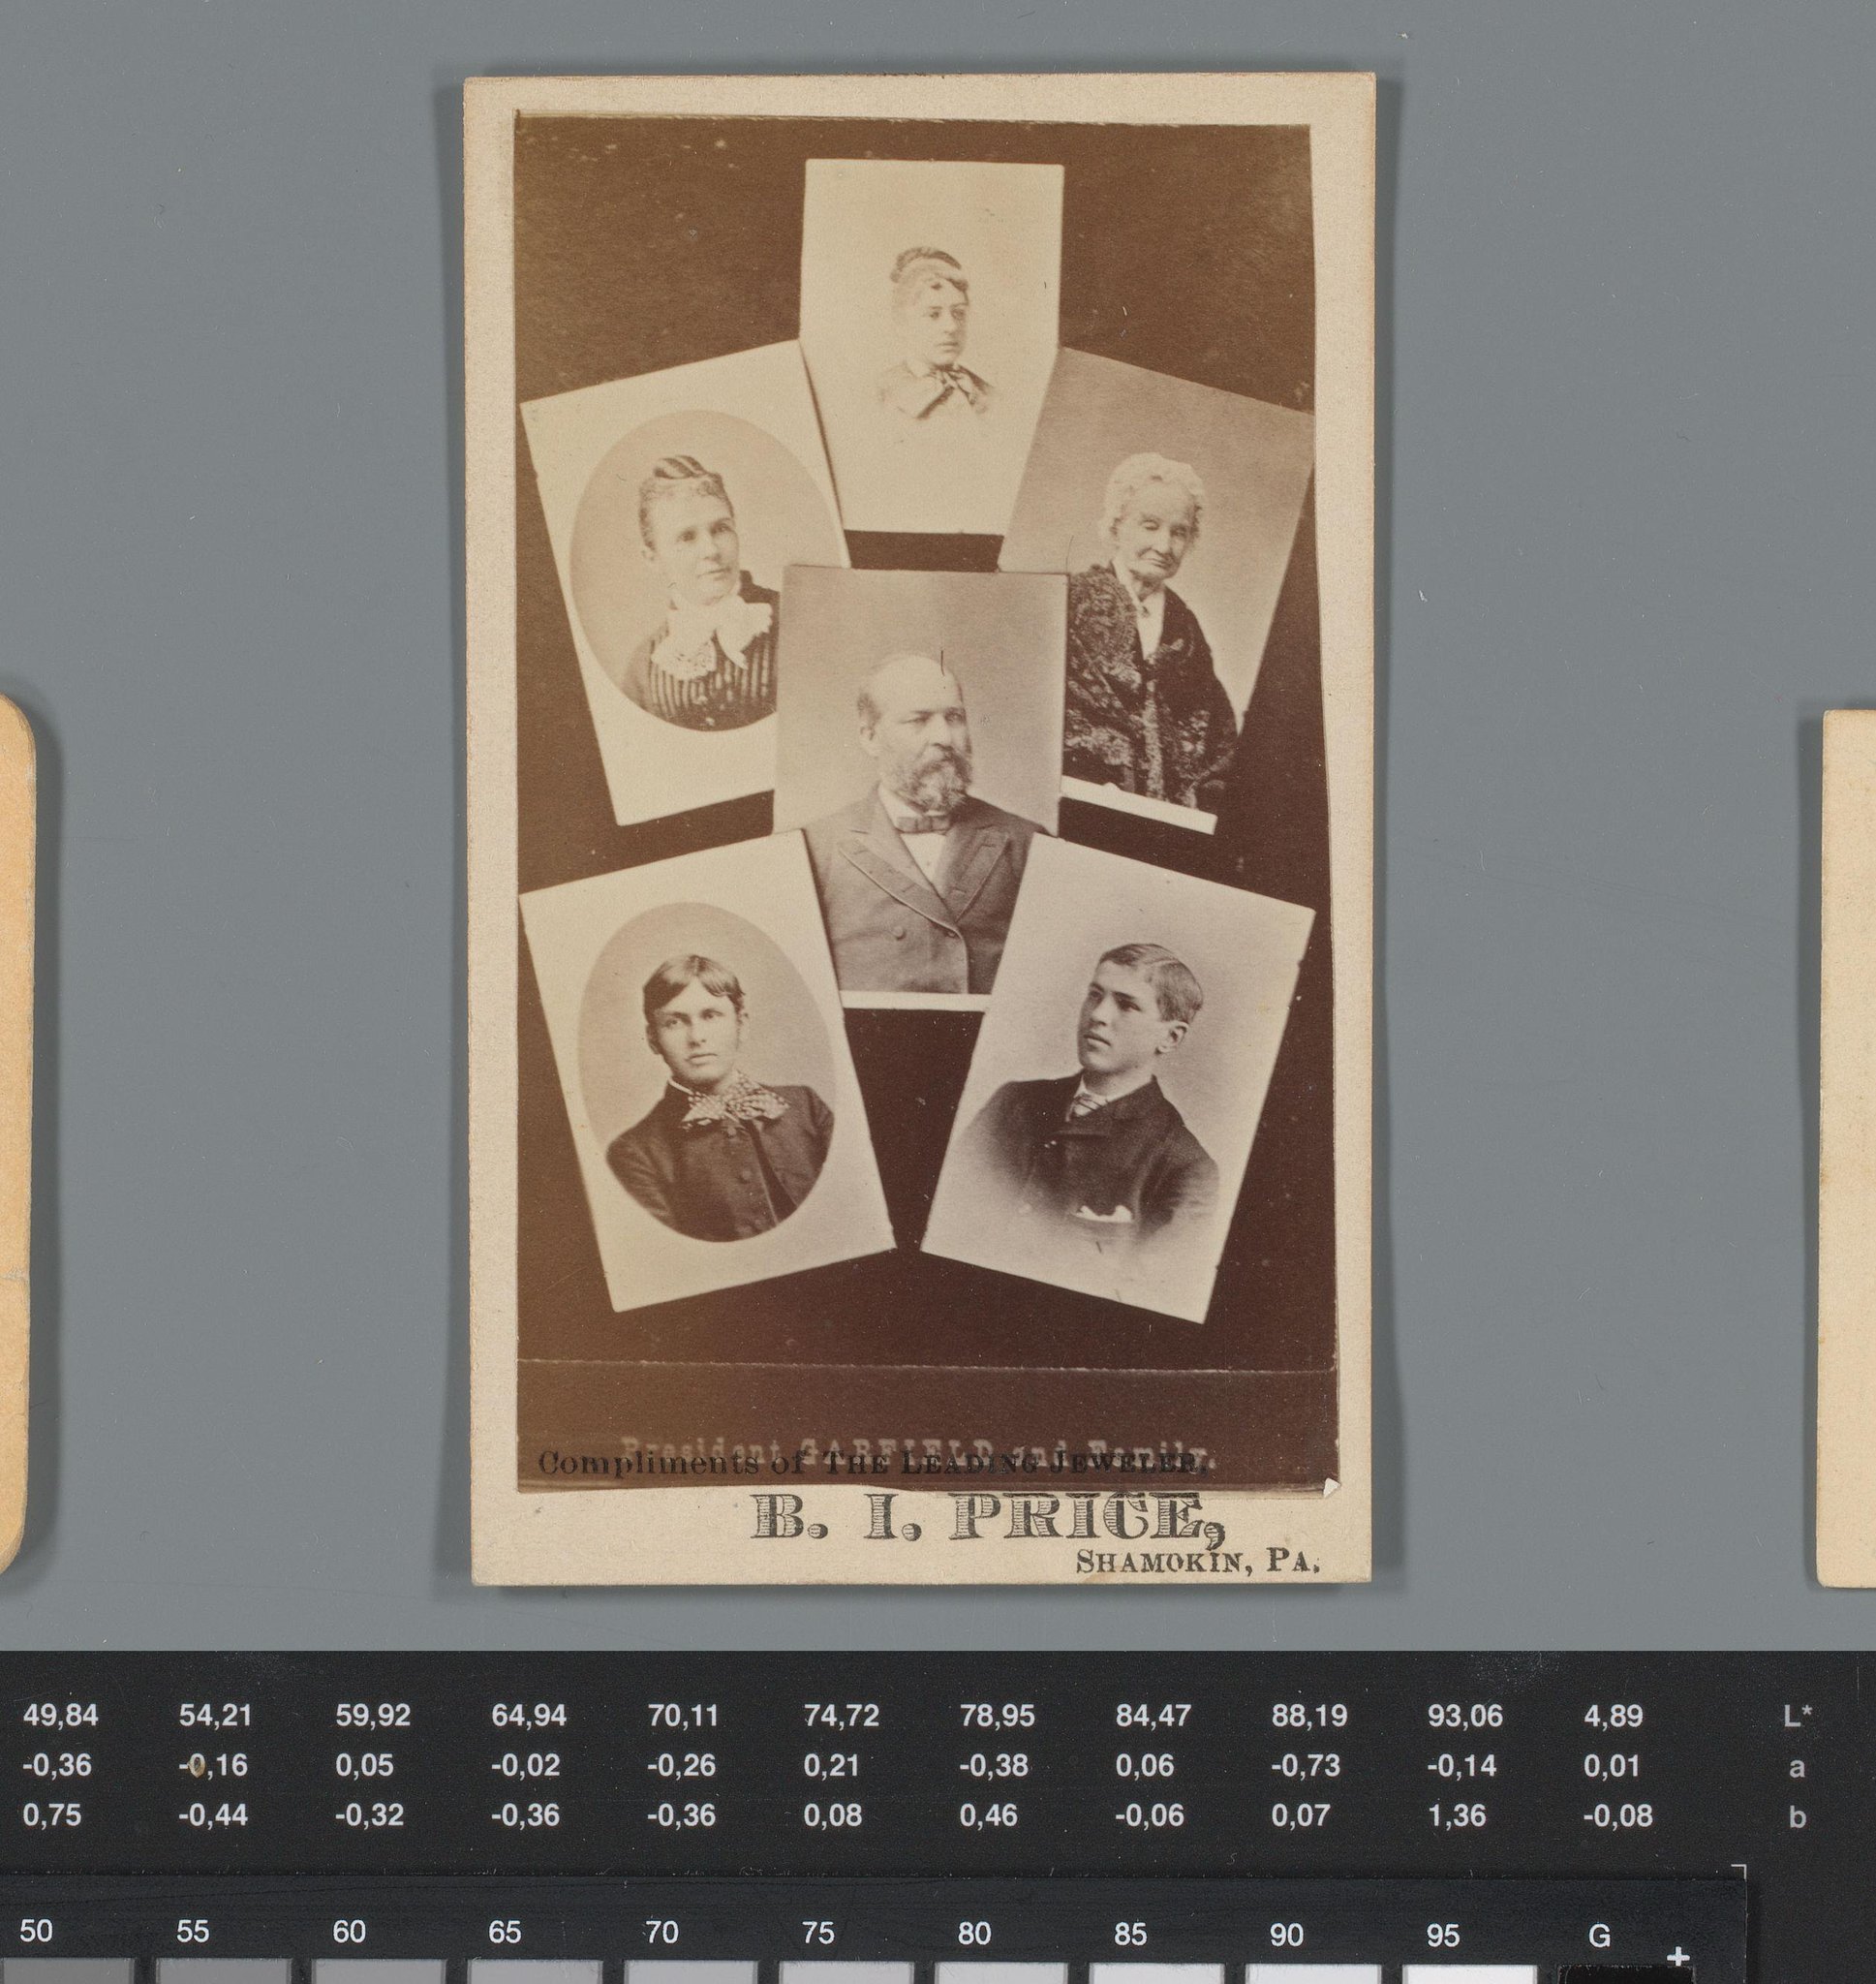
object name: carte de visite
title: Reclame voor zilverwaren en sieraden van B.I. Price te Shamokin met portretten van James en Lucretia Garfield en hun familie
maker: Anonymous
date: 1850-1915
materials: cardboard, photographic support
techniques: albumen print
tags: advertising, historical persons - bb - woman, historical persons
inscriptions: inscription: ‘SILVERWARE. (...) RINGS. (...) AND IN FACT EVERYTHING THAT CAN BE FOUND IN A FIRST-CLASS FEWELRY STORE. / B.I. PRICE, The Leading Jeweller, / SHAMOKIN, PA’